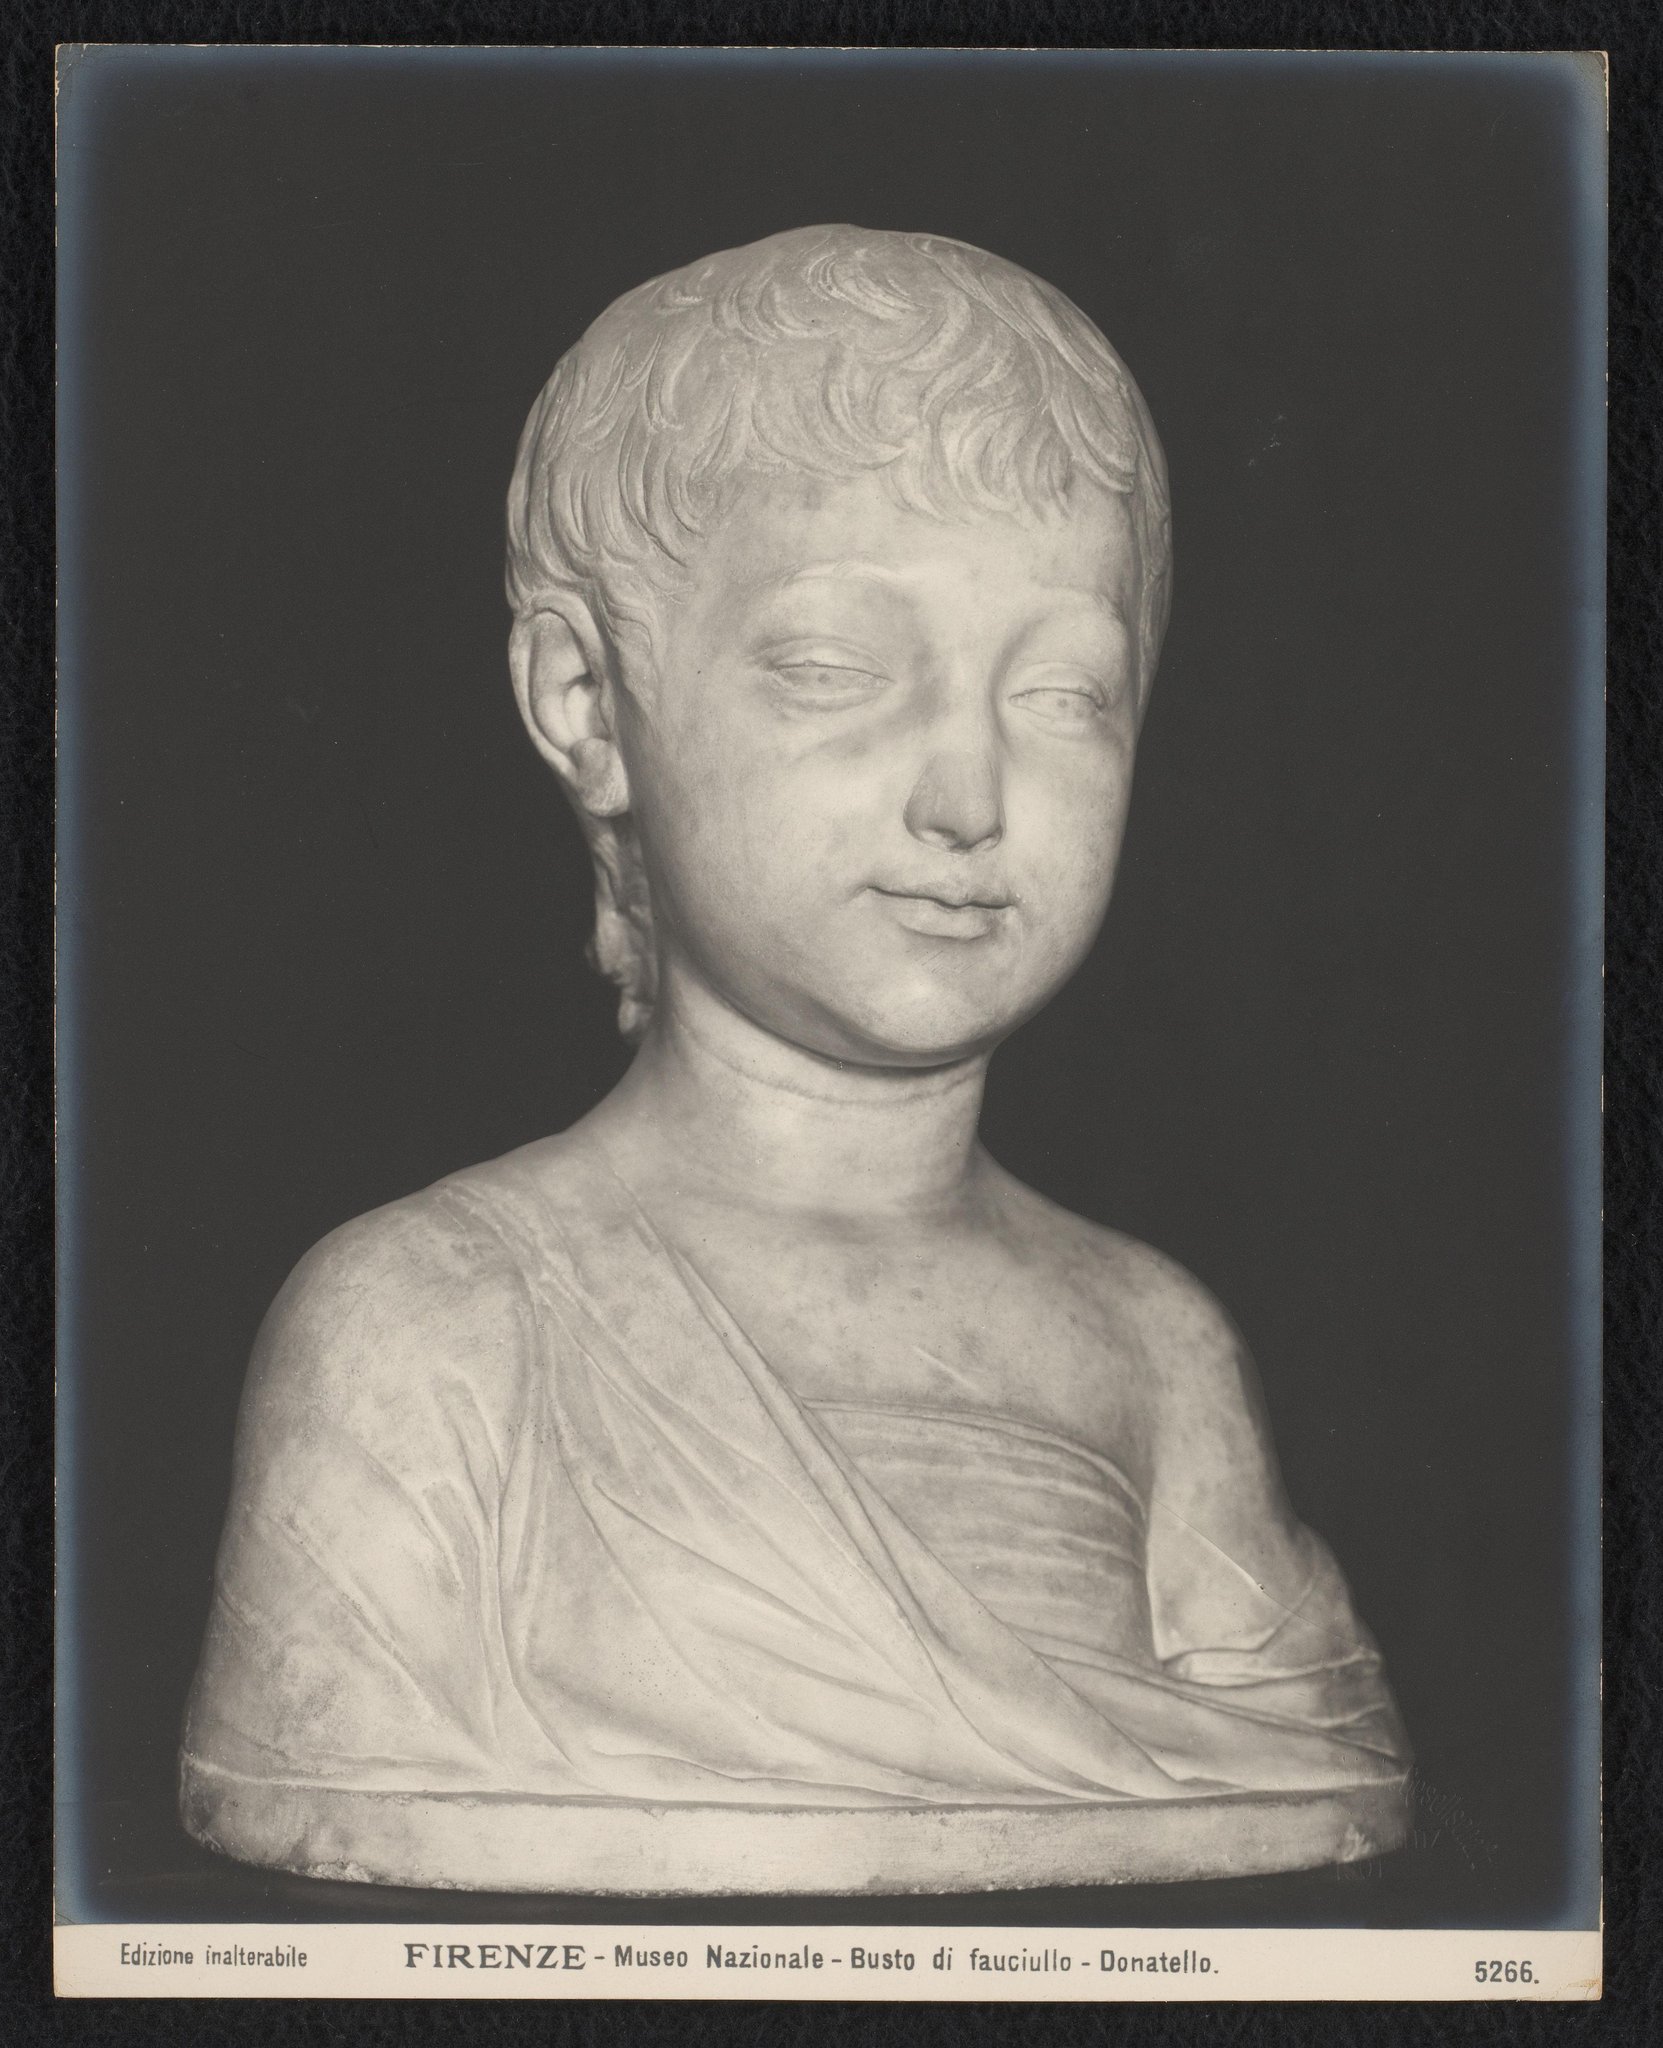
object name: photograph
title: Museo Nazionale - Busto di fauciullo - Donatello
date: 1901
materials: paper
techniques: gelatin silver print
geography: berlin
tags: head (human), boy (child between toddler and youth), piece of sculpture, reproduction of a piece of sculpture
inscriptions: collector's mark: ‘RIJKS SCHOOL VOOR KUNSTNIJVERHEID/ GROEP’, number: ‘5266.’, inscription: ‘Edizione inalterabile.’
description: Deze foto maakt deel uit van een omslag.